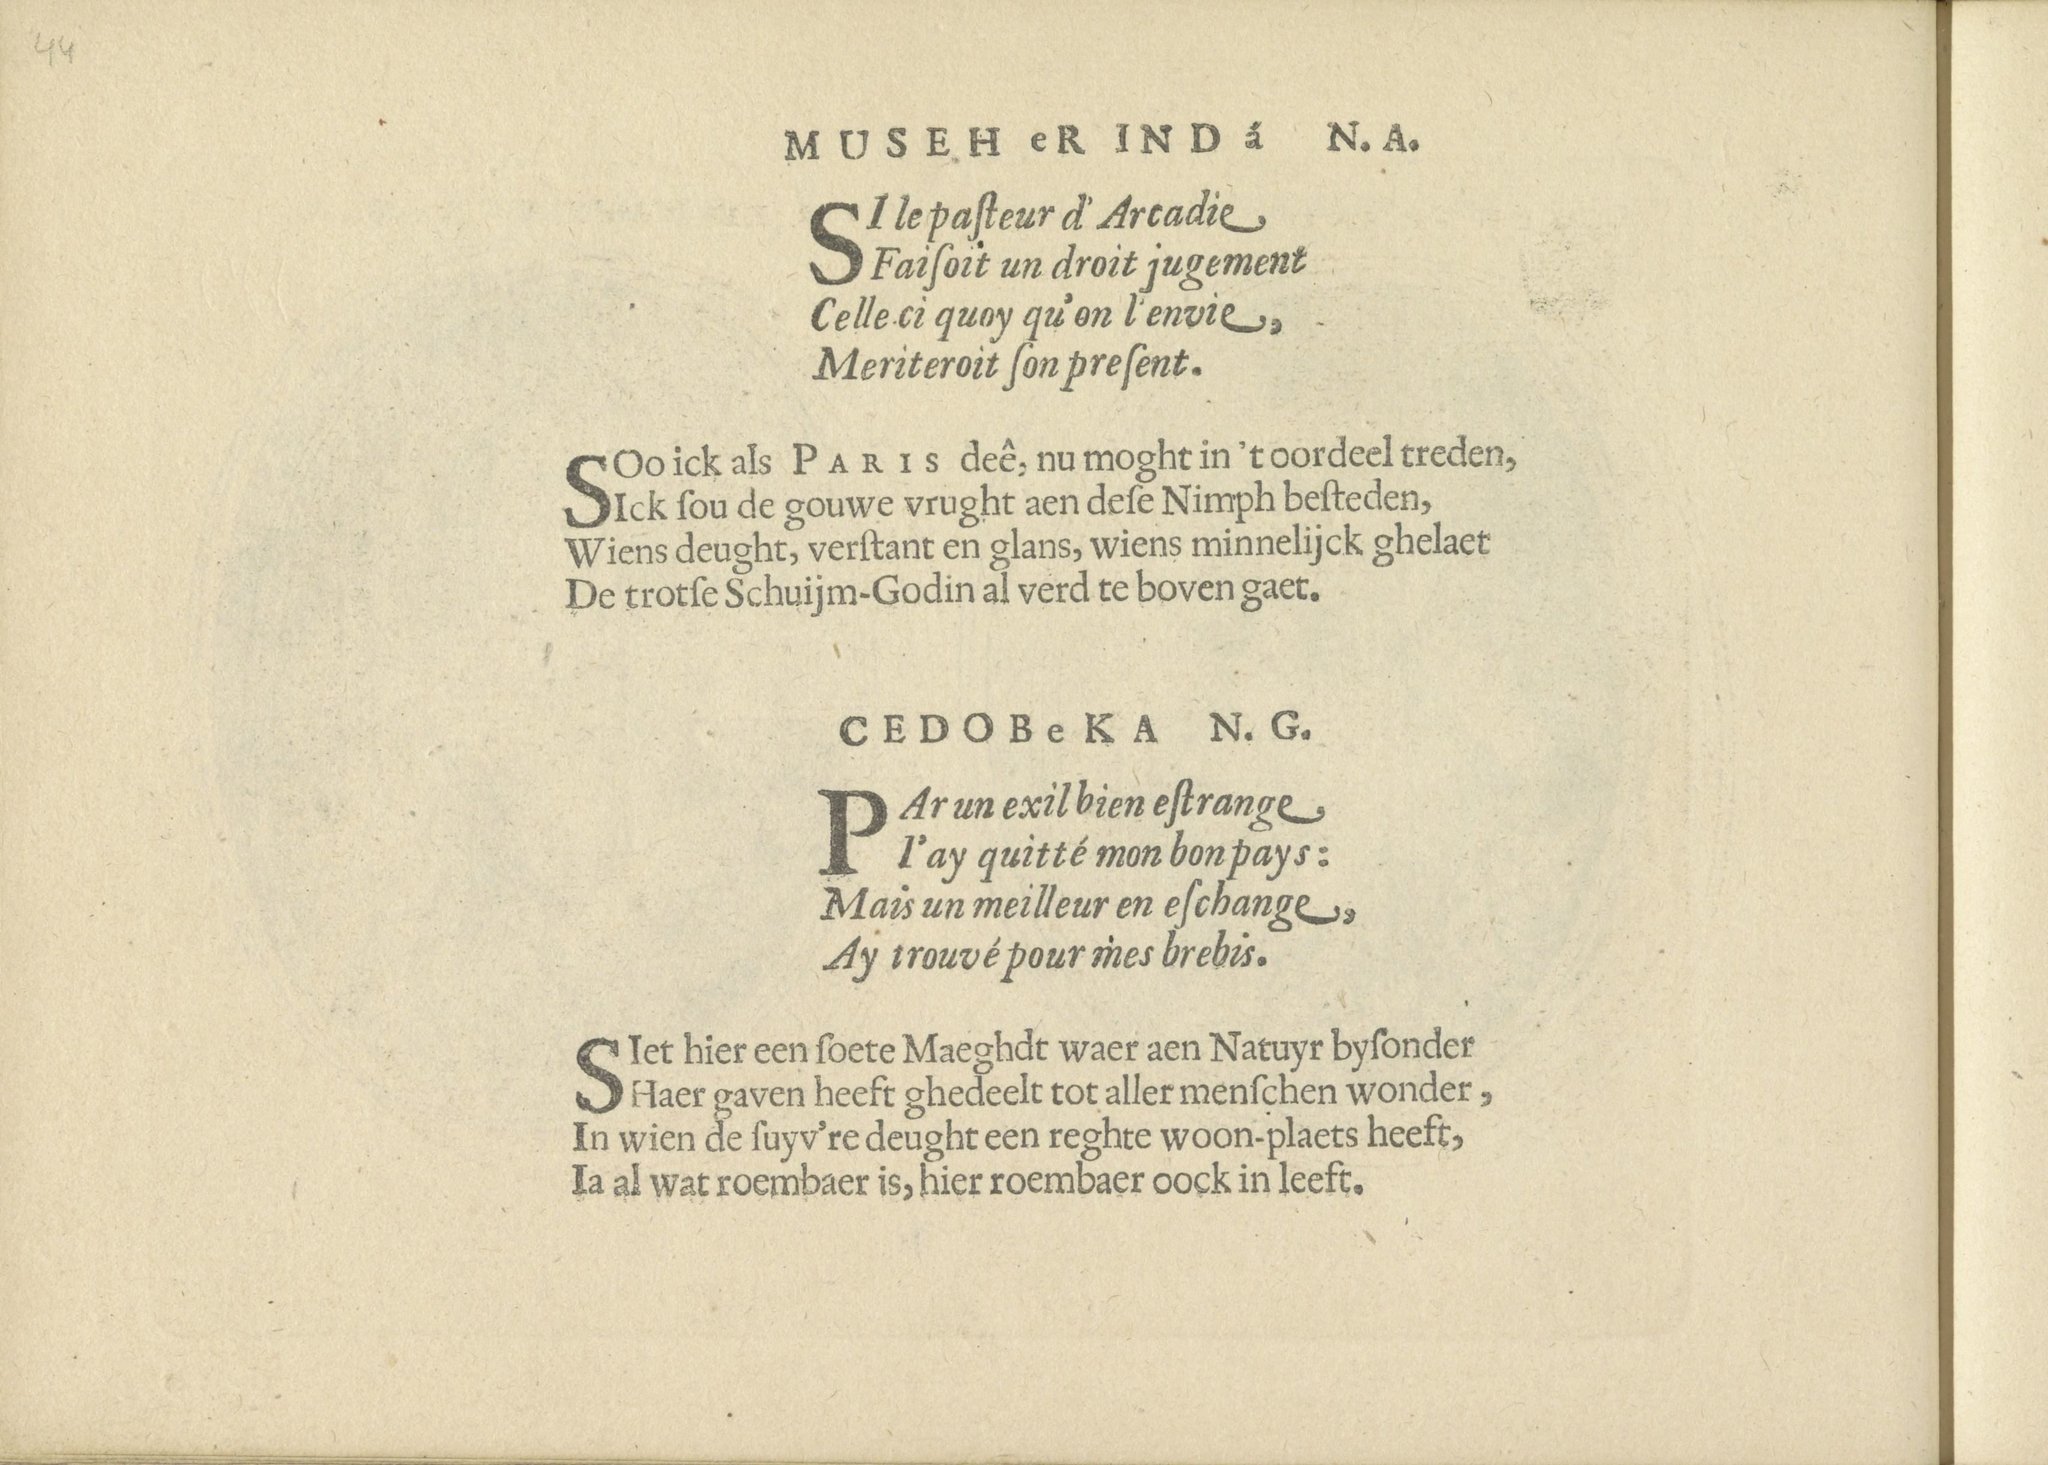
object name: album leaf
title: Kwatrijnen bij de voorstellingen van Museherinda N.A. en Cedobeka N.G.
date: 1640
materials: paper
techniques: letterpress printing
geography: amsterdam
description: Twee keer twee kwatrijnen in het Frans en Nederlands bij de voorstellingen van Museherinda N.A. en Cedobeka N.G. Het blad maakt deel uit van een album.